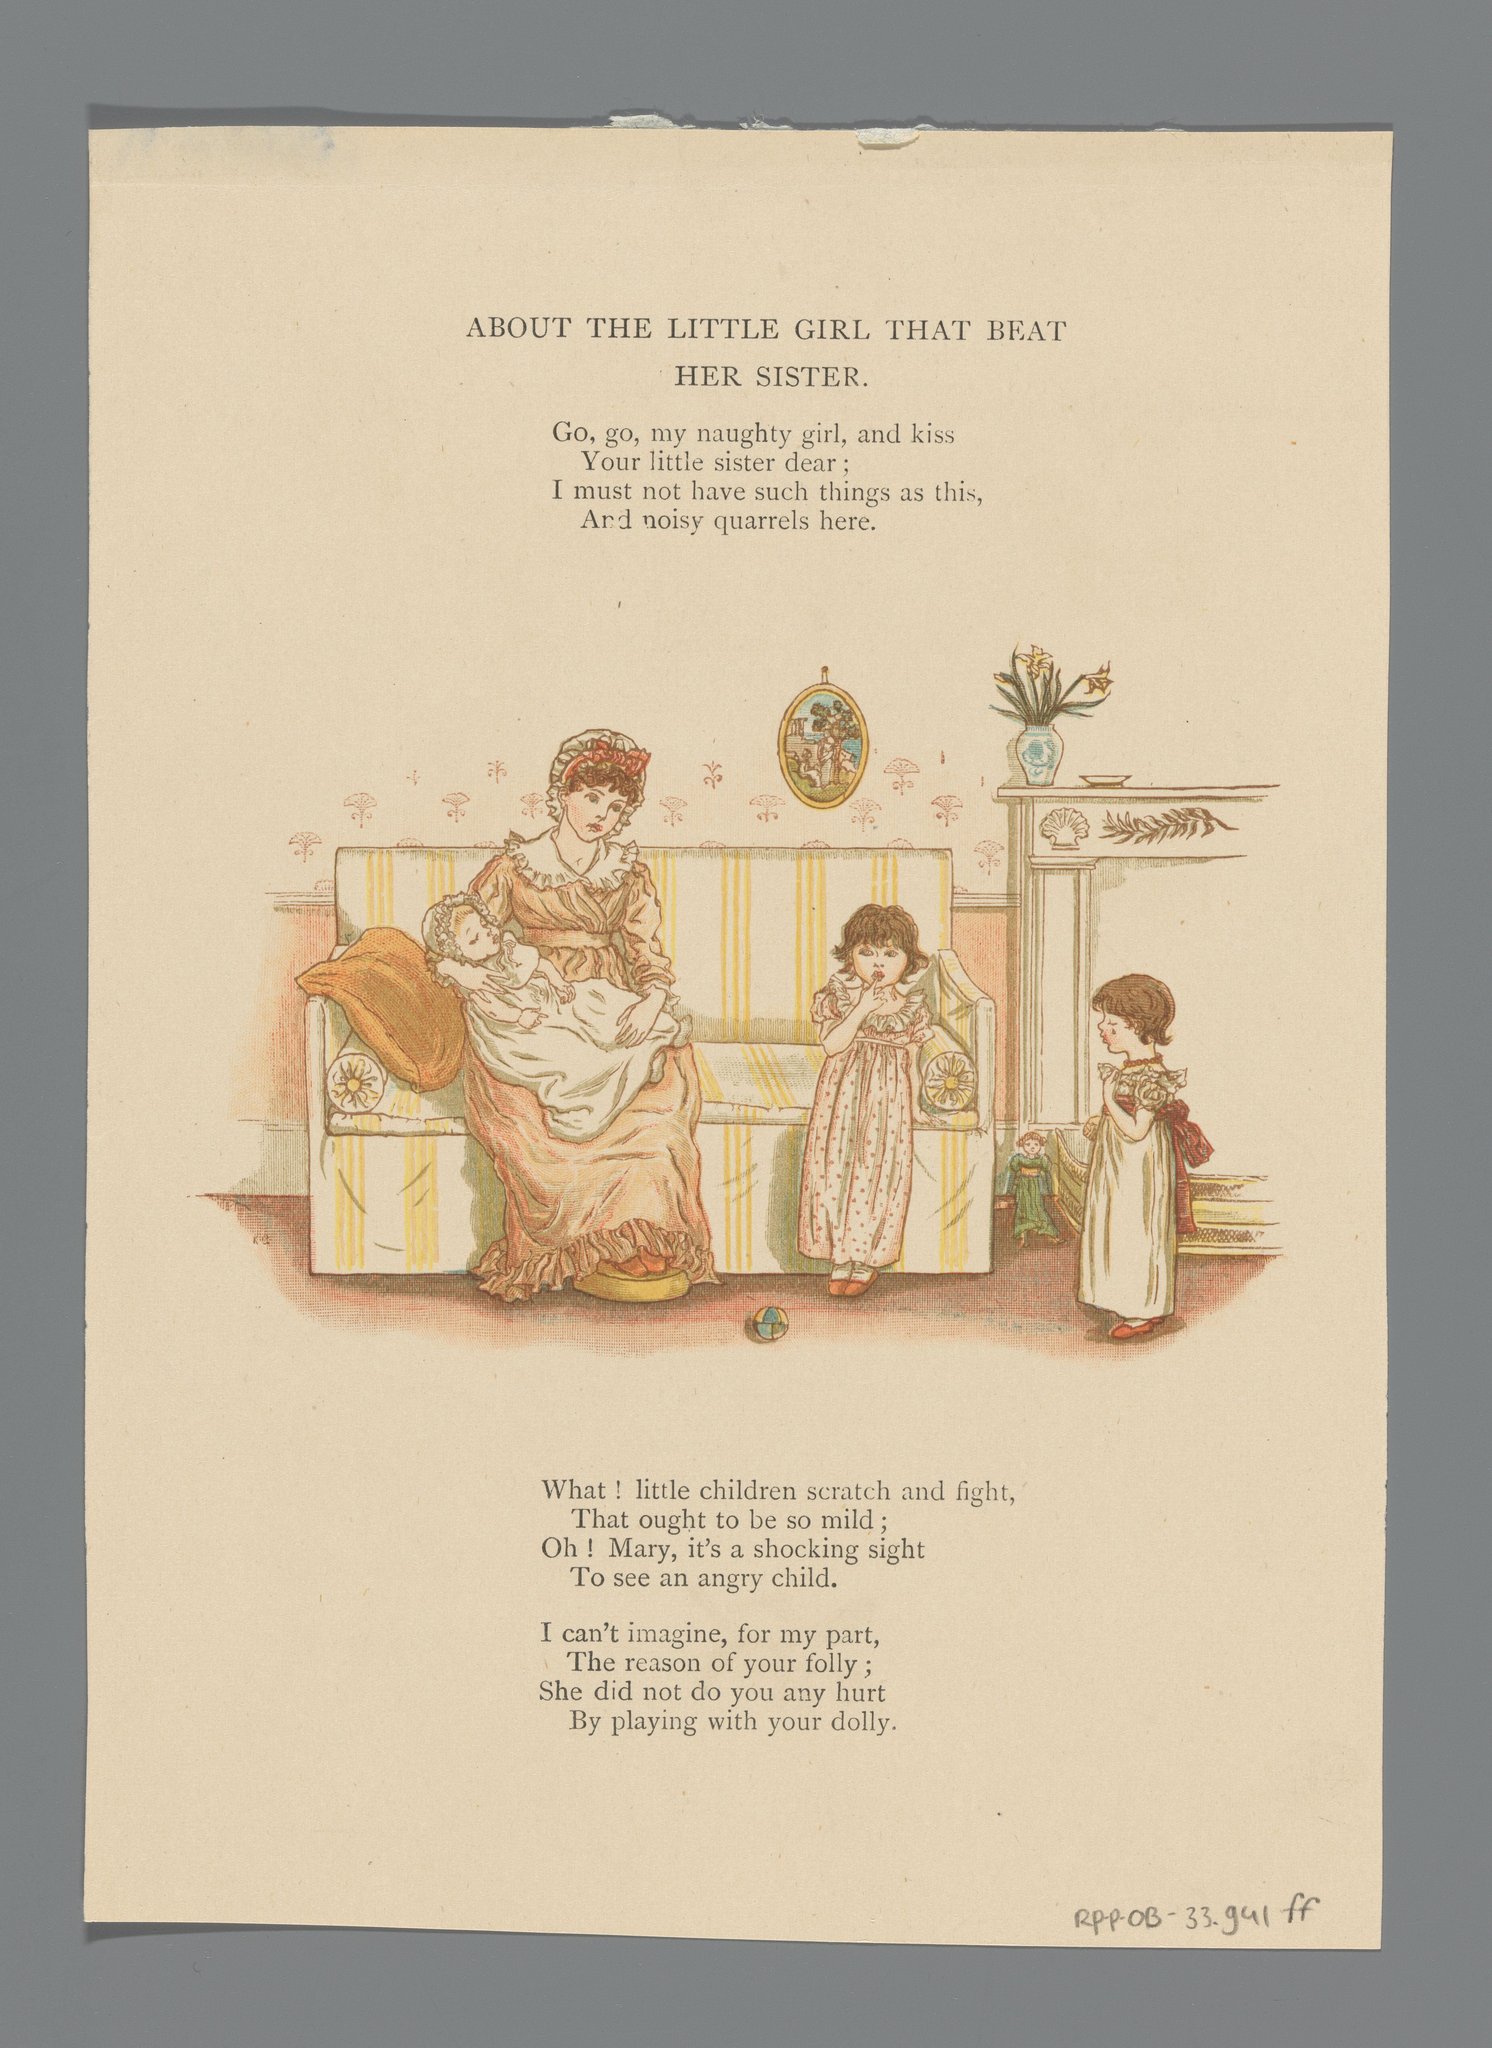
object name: book illustration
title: Familie in een huiskamer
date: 1883-1927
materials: paper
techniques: wood engraving, letterpress printing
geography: london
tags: family life at home, living-room, parlour, sitting-room, mother and child(ren), woman and child(ren) (family group)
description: Prent uit: Jane en Ann Taylor. Little Ann and other poems. Londen: George Routledge & Sons, [1883], p. 62. Of een latere uitgave.